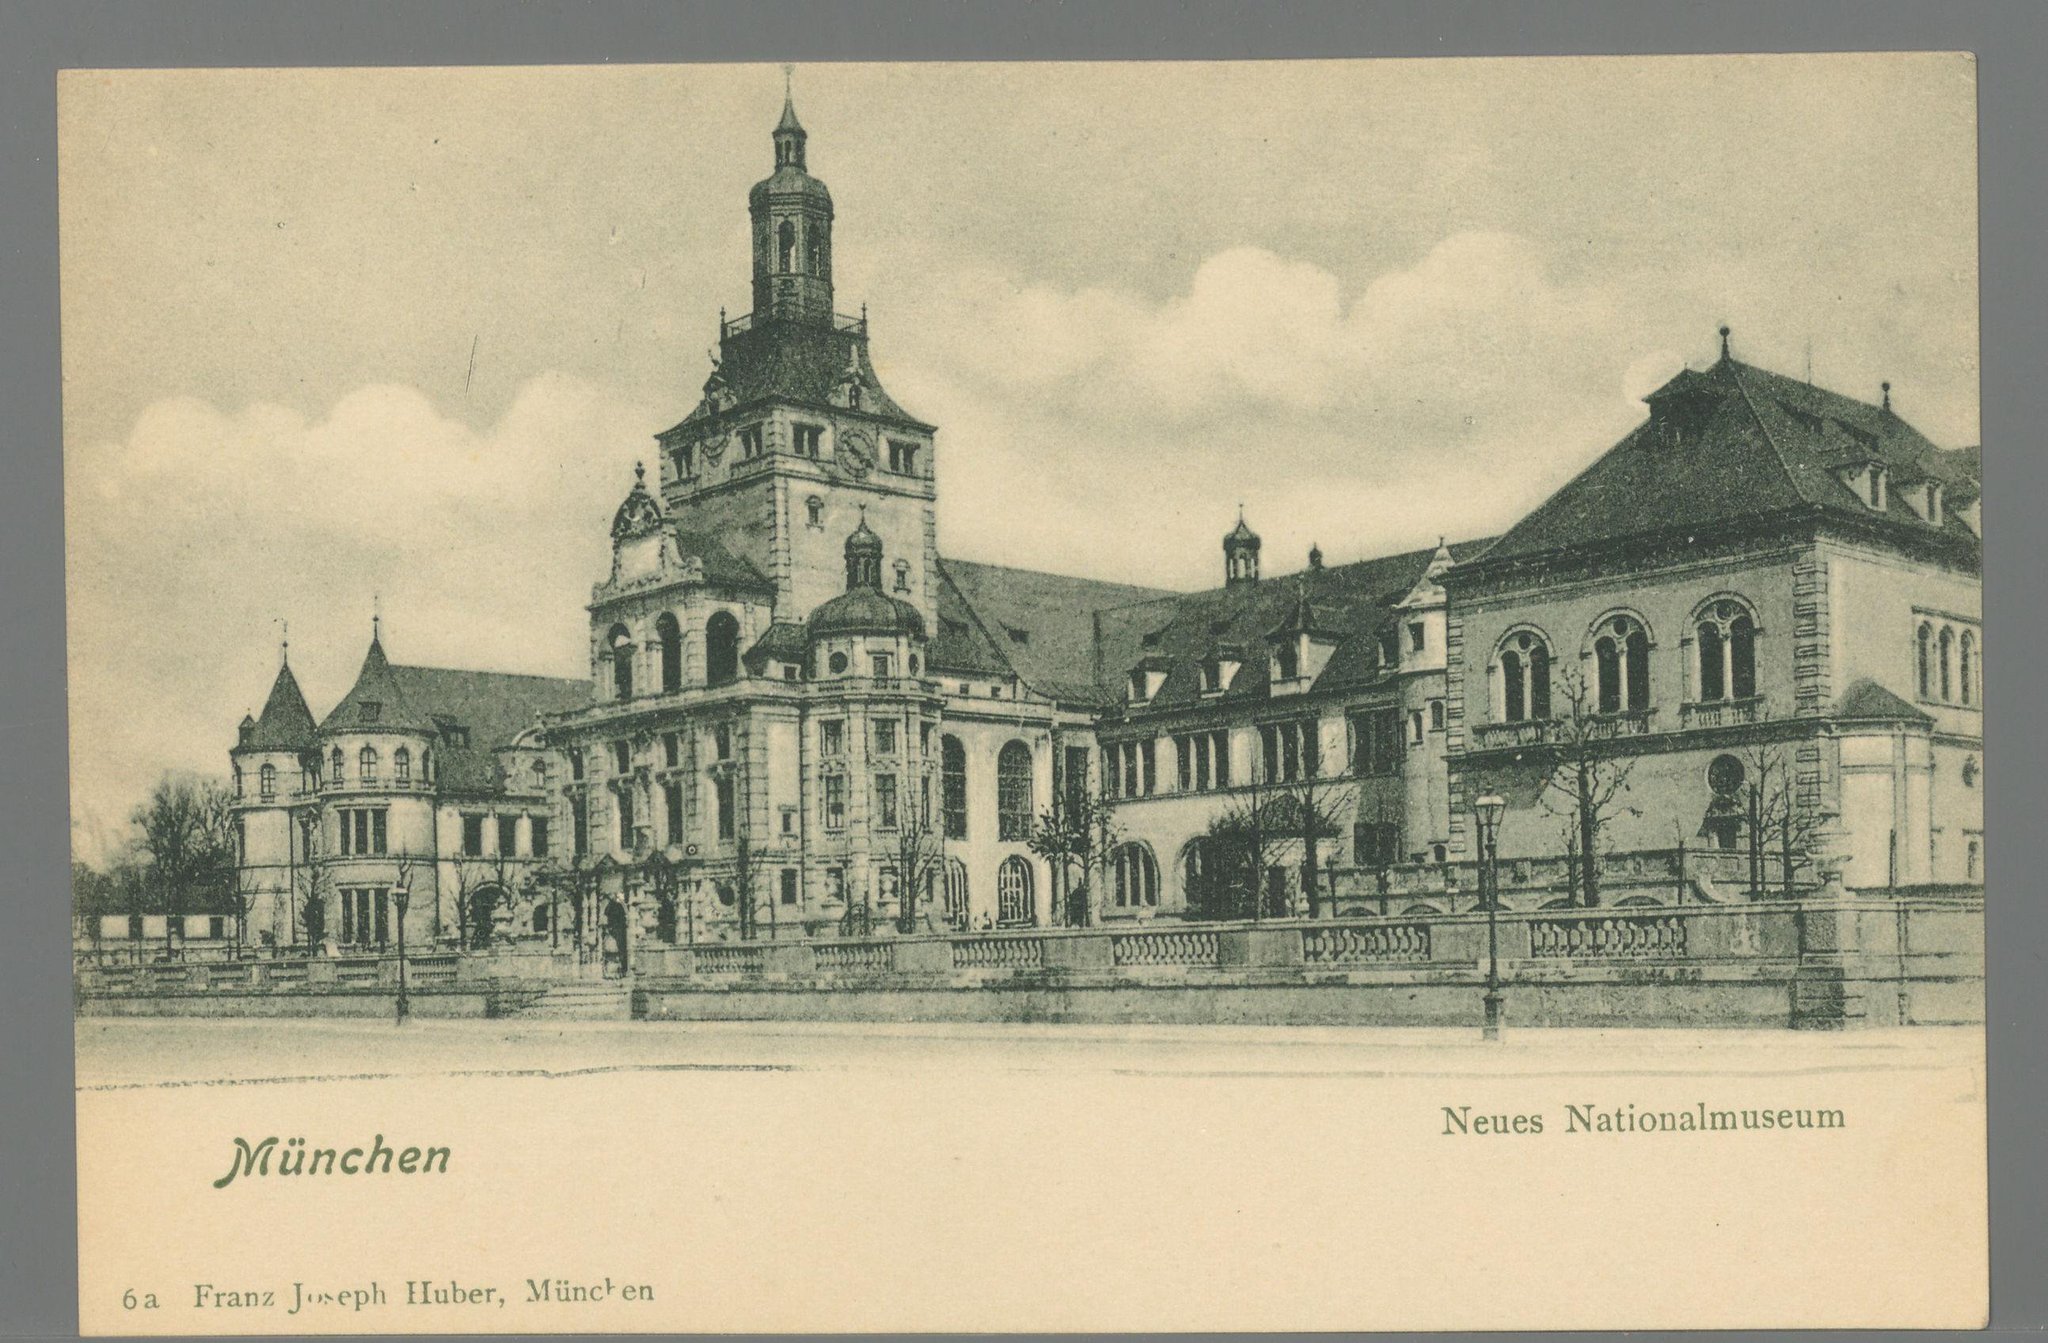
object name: photomechanical print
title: München. Neues Nationalmuseum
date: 1885-1905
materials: cardboard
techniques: photograph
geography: munich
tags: permanent exhibition, museum